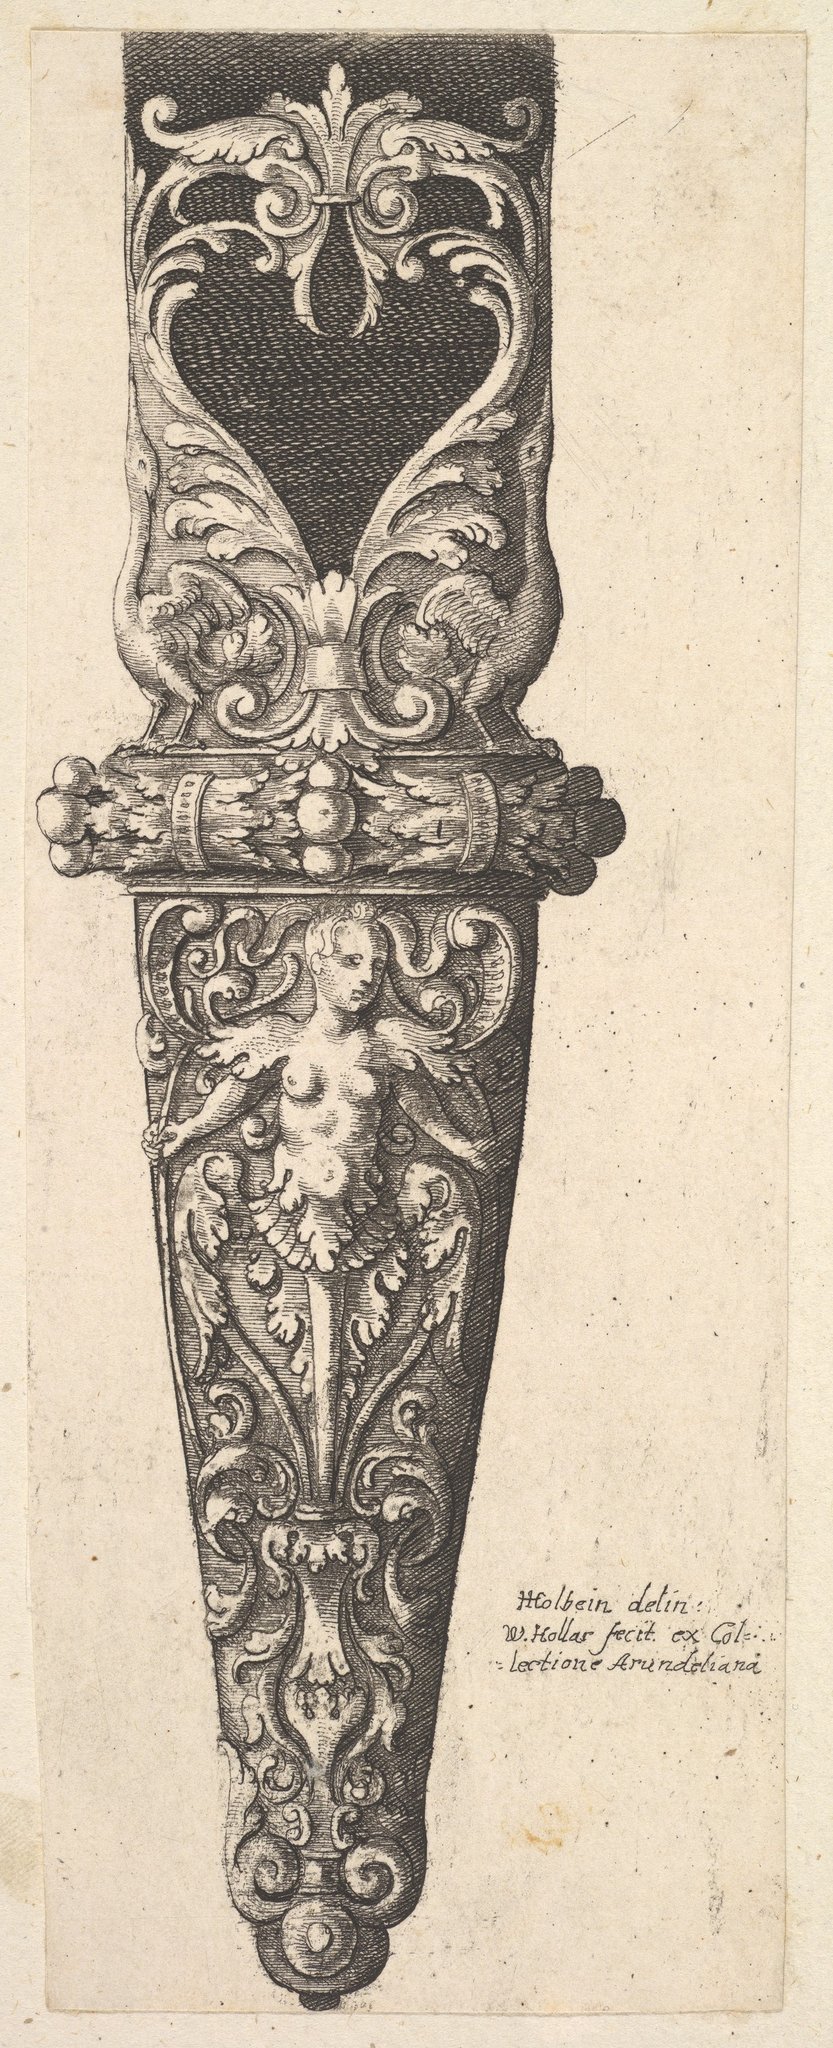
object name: print ornament architecture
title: Lower portion of a scabbard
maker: wenceslaus hollar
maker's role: artist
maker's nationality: bohemian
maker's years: 1607-1677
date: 1645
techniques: etching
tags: birds,military equipment,palmettes